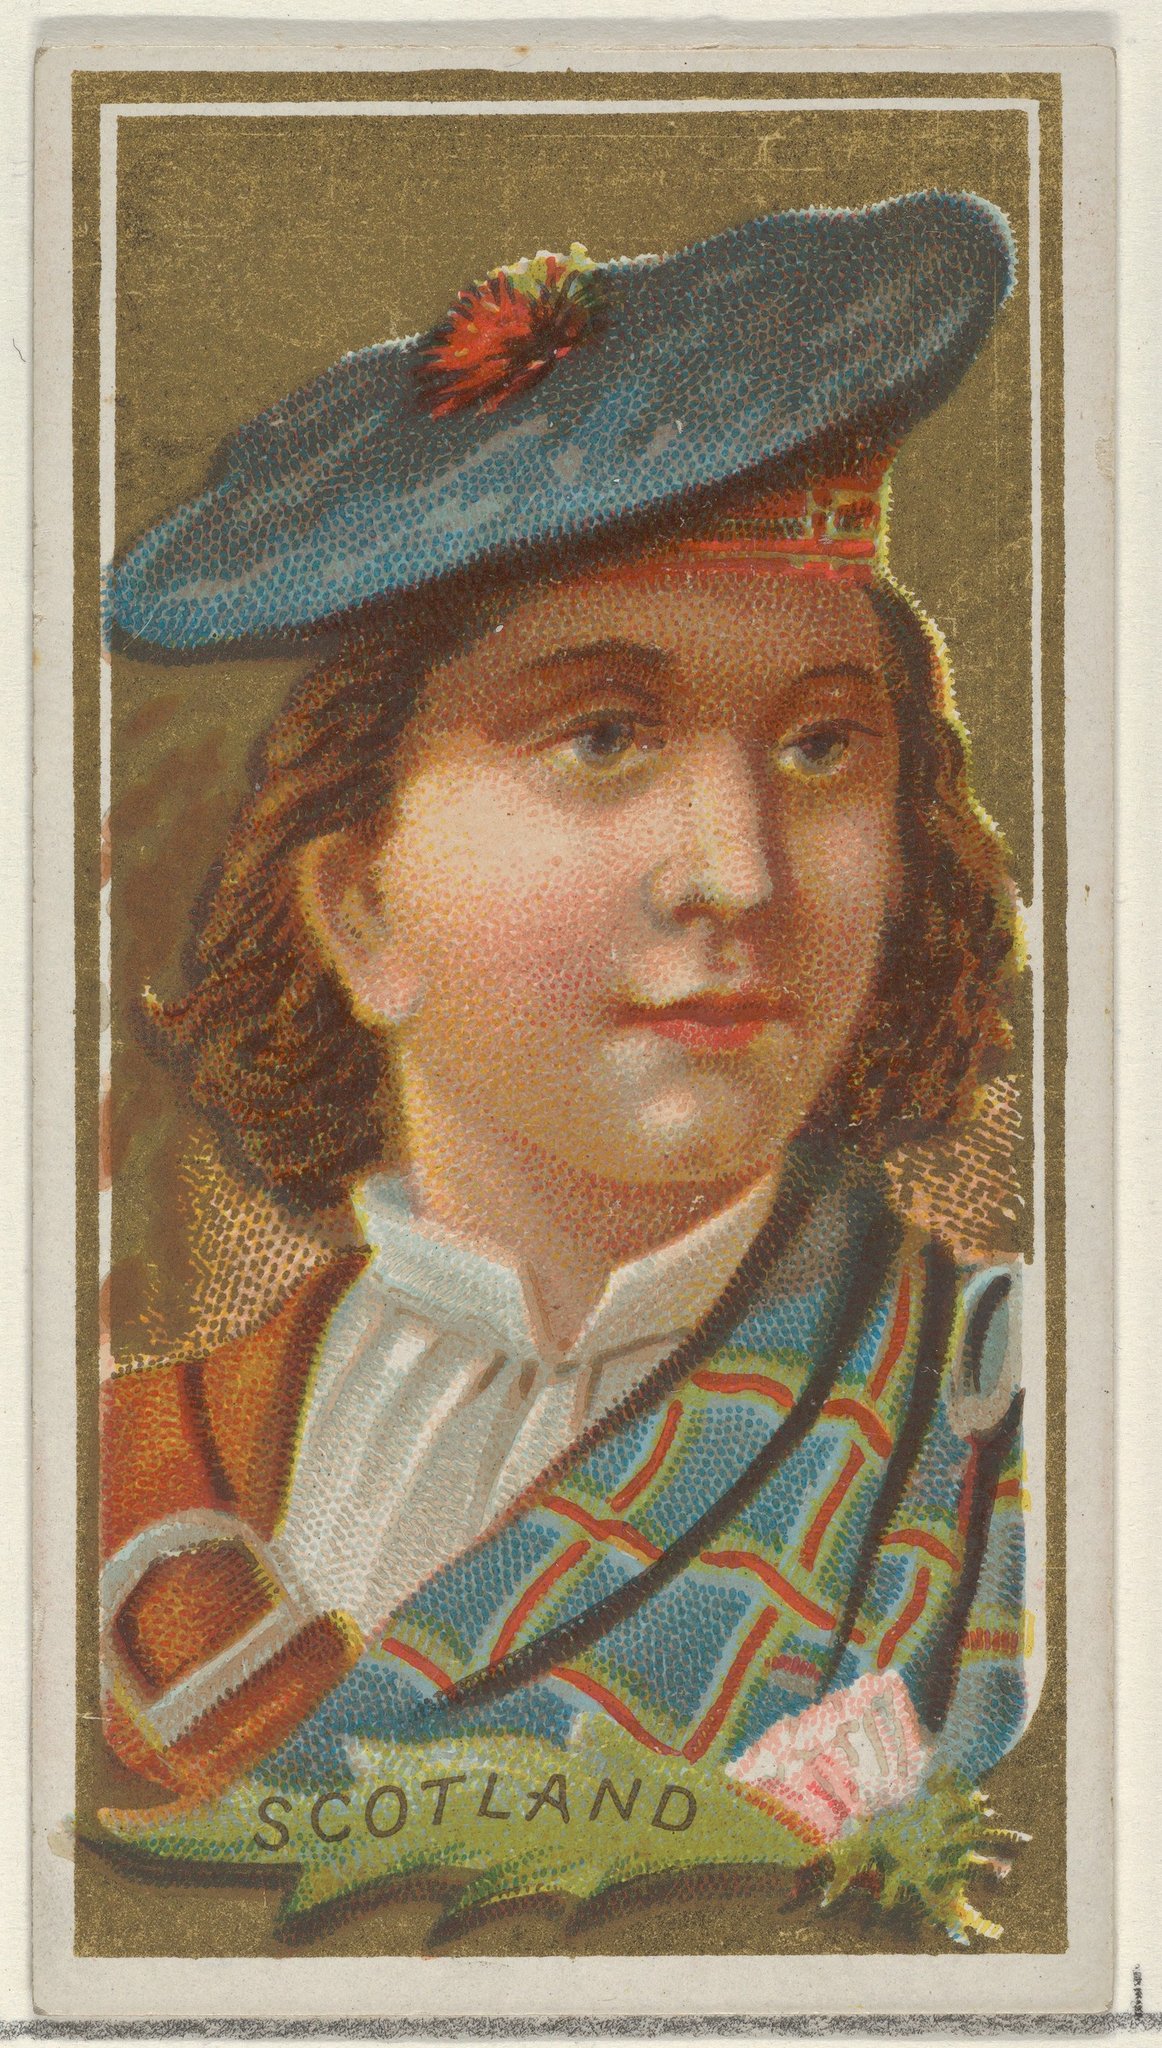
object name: print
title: Scotland, from the Types of All Nations series (N24) for Allen & Ginter Cigarettes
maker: allen & ginter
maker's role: publisher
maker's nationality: american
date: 1889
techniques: color lithograph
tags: men